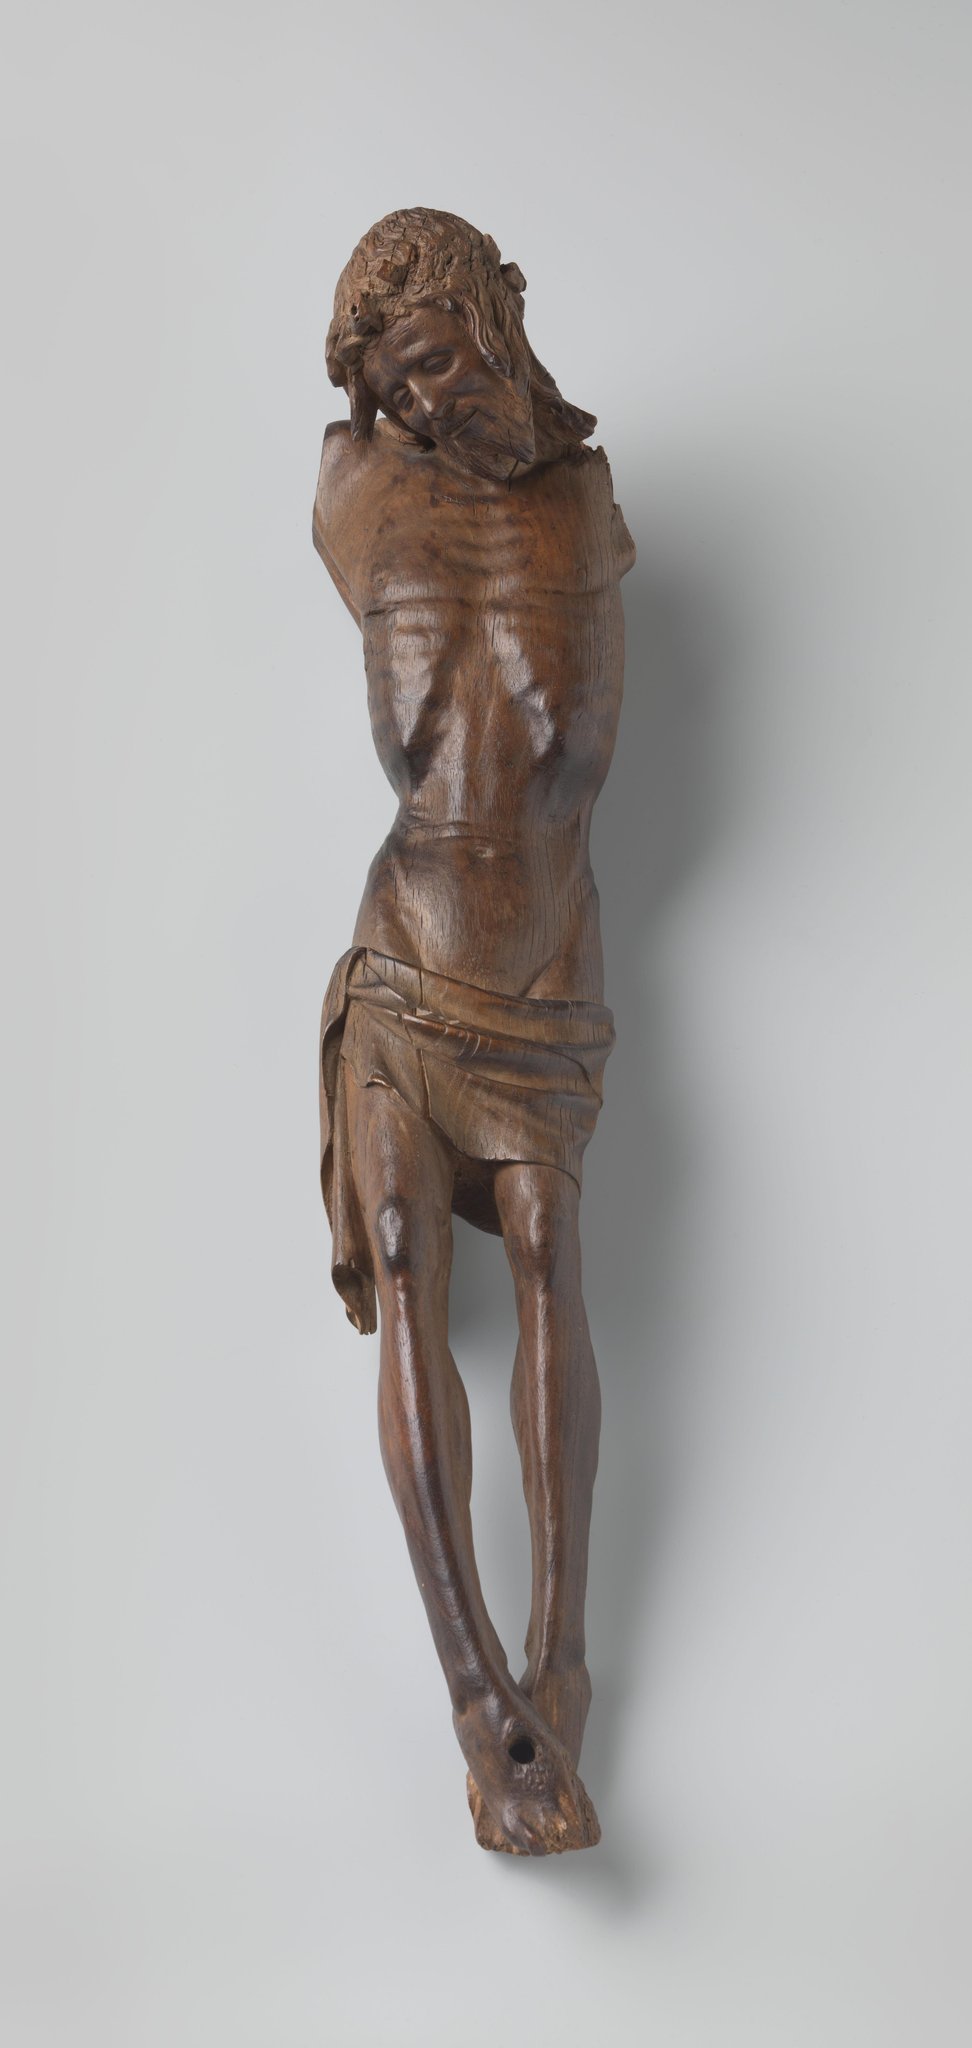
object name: crucifix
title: Crucified Christ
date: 1400-1425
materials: wood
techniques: cutting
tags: altarcross, crucifix, specific types of crucified christ (in non-narrative context)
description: Because this crucifix originally hung in the church of Bunde, a small village near Maastricht, it is assumed to have originated in the Meuse River region (Mosan). In the Middle Ages this region was an important breeding ground for art. With Christ’s imposingly stylized, elongated body, this crucifix is closely connected to the courtly style in Paris, where many artists from the Netherlands were active around 1400.